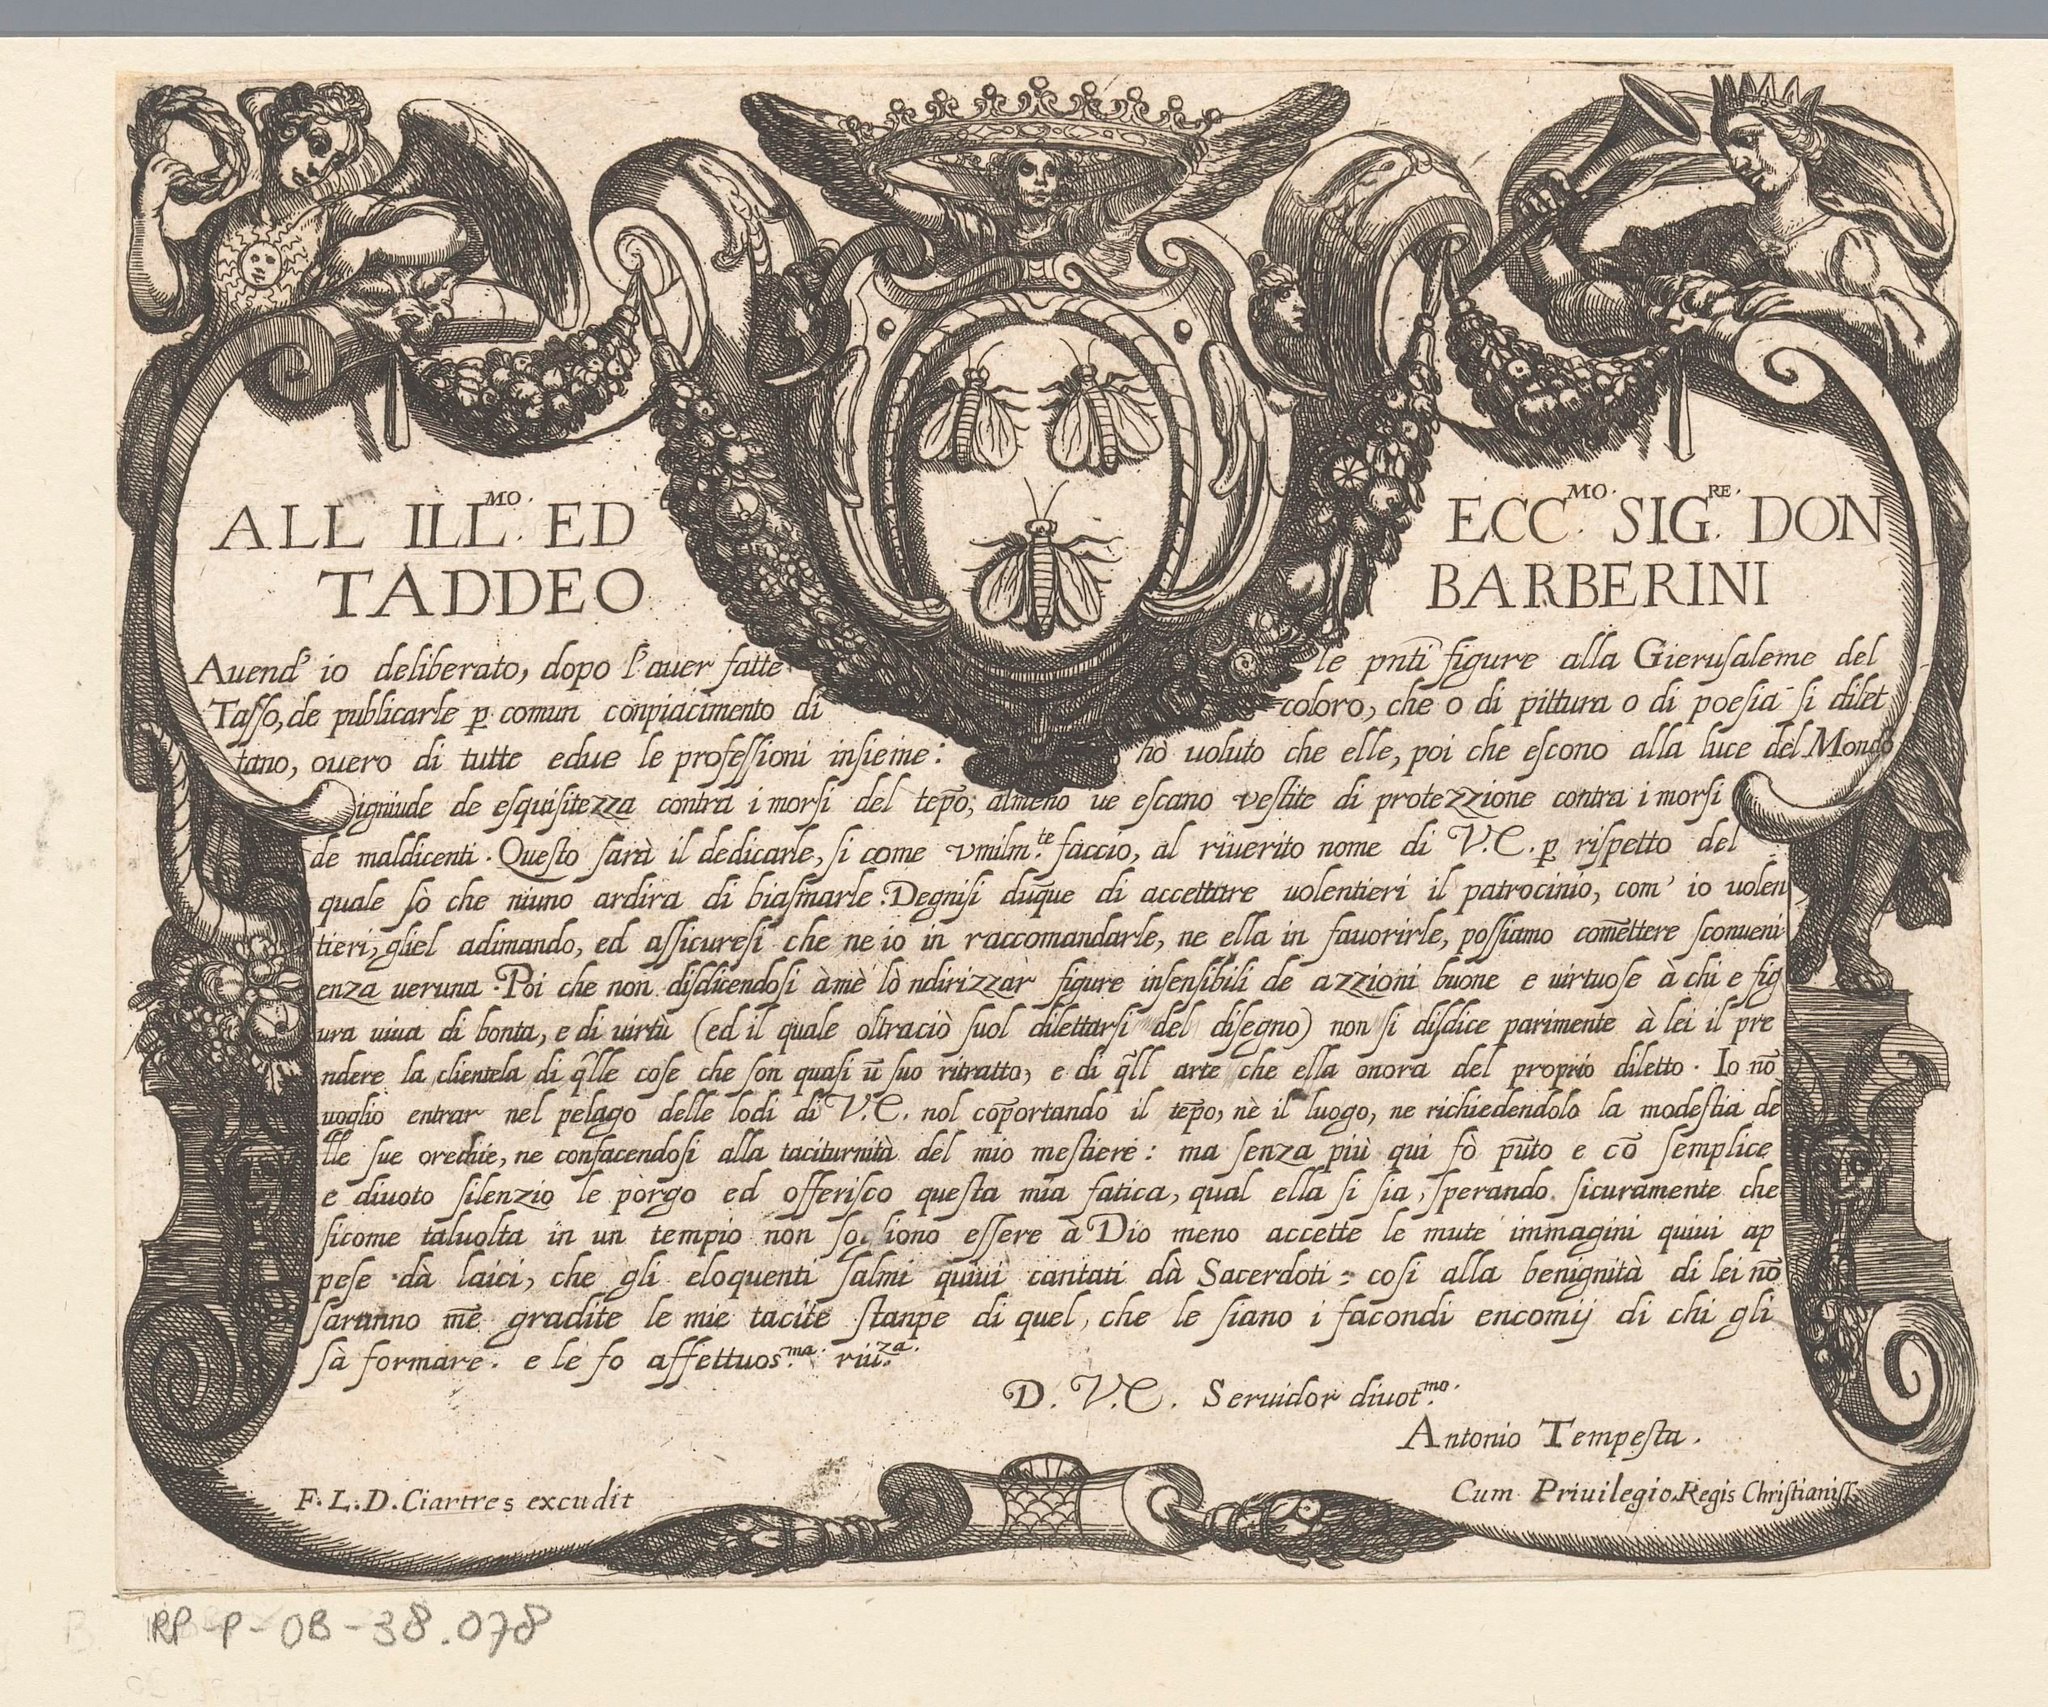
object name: print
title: Cartouche met gekroond wapenschild en opdracht aan Taddeo Barberini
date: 1565-1630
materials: paper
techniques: etching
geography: vatican city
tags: coat of arms (symbol of sovereignty), ornament ~ cartouche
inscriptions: collector's mark: Lugt 240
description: Opdracht bij een reeks van twintig prenten met voorstellingen van scènes uit Tasso's 'Jeruzalem verlost', een episch gedicht geschreven door de Italiaanse dichter Torquato Tasso en voor het eerst gepubliceerd in 1581. Het verhaal vertelt grotendeels in fictie over de Eerste Kruistocht waarin de christenen, geleid door Godfried van Bouillon, de strijd aangaan met de moslims om het Beleg van Jeruzalem.